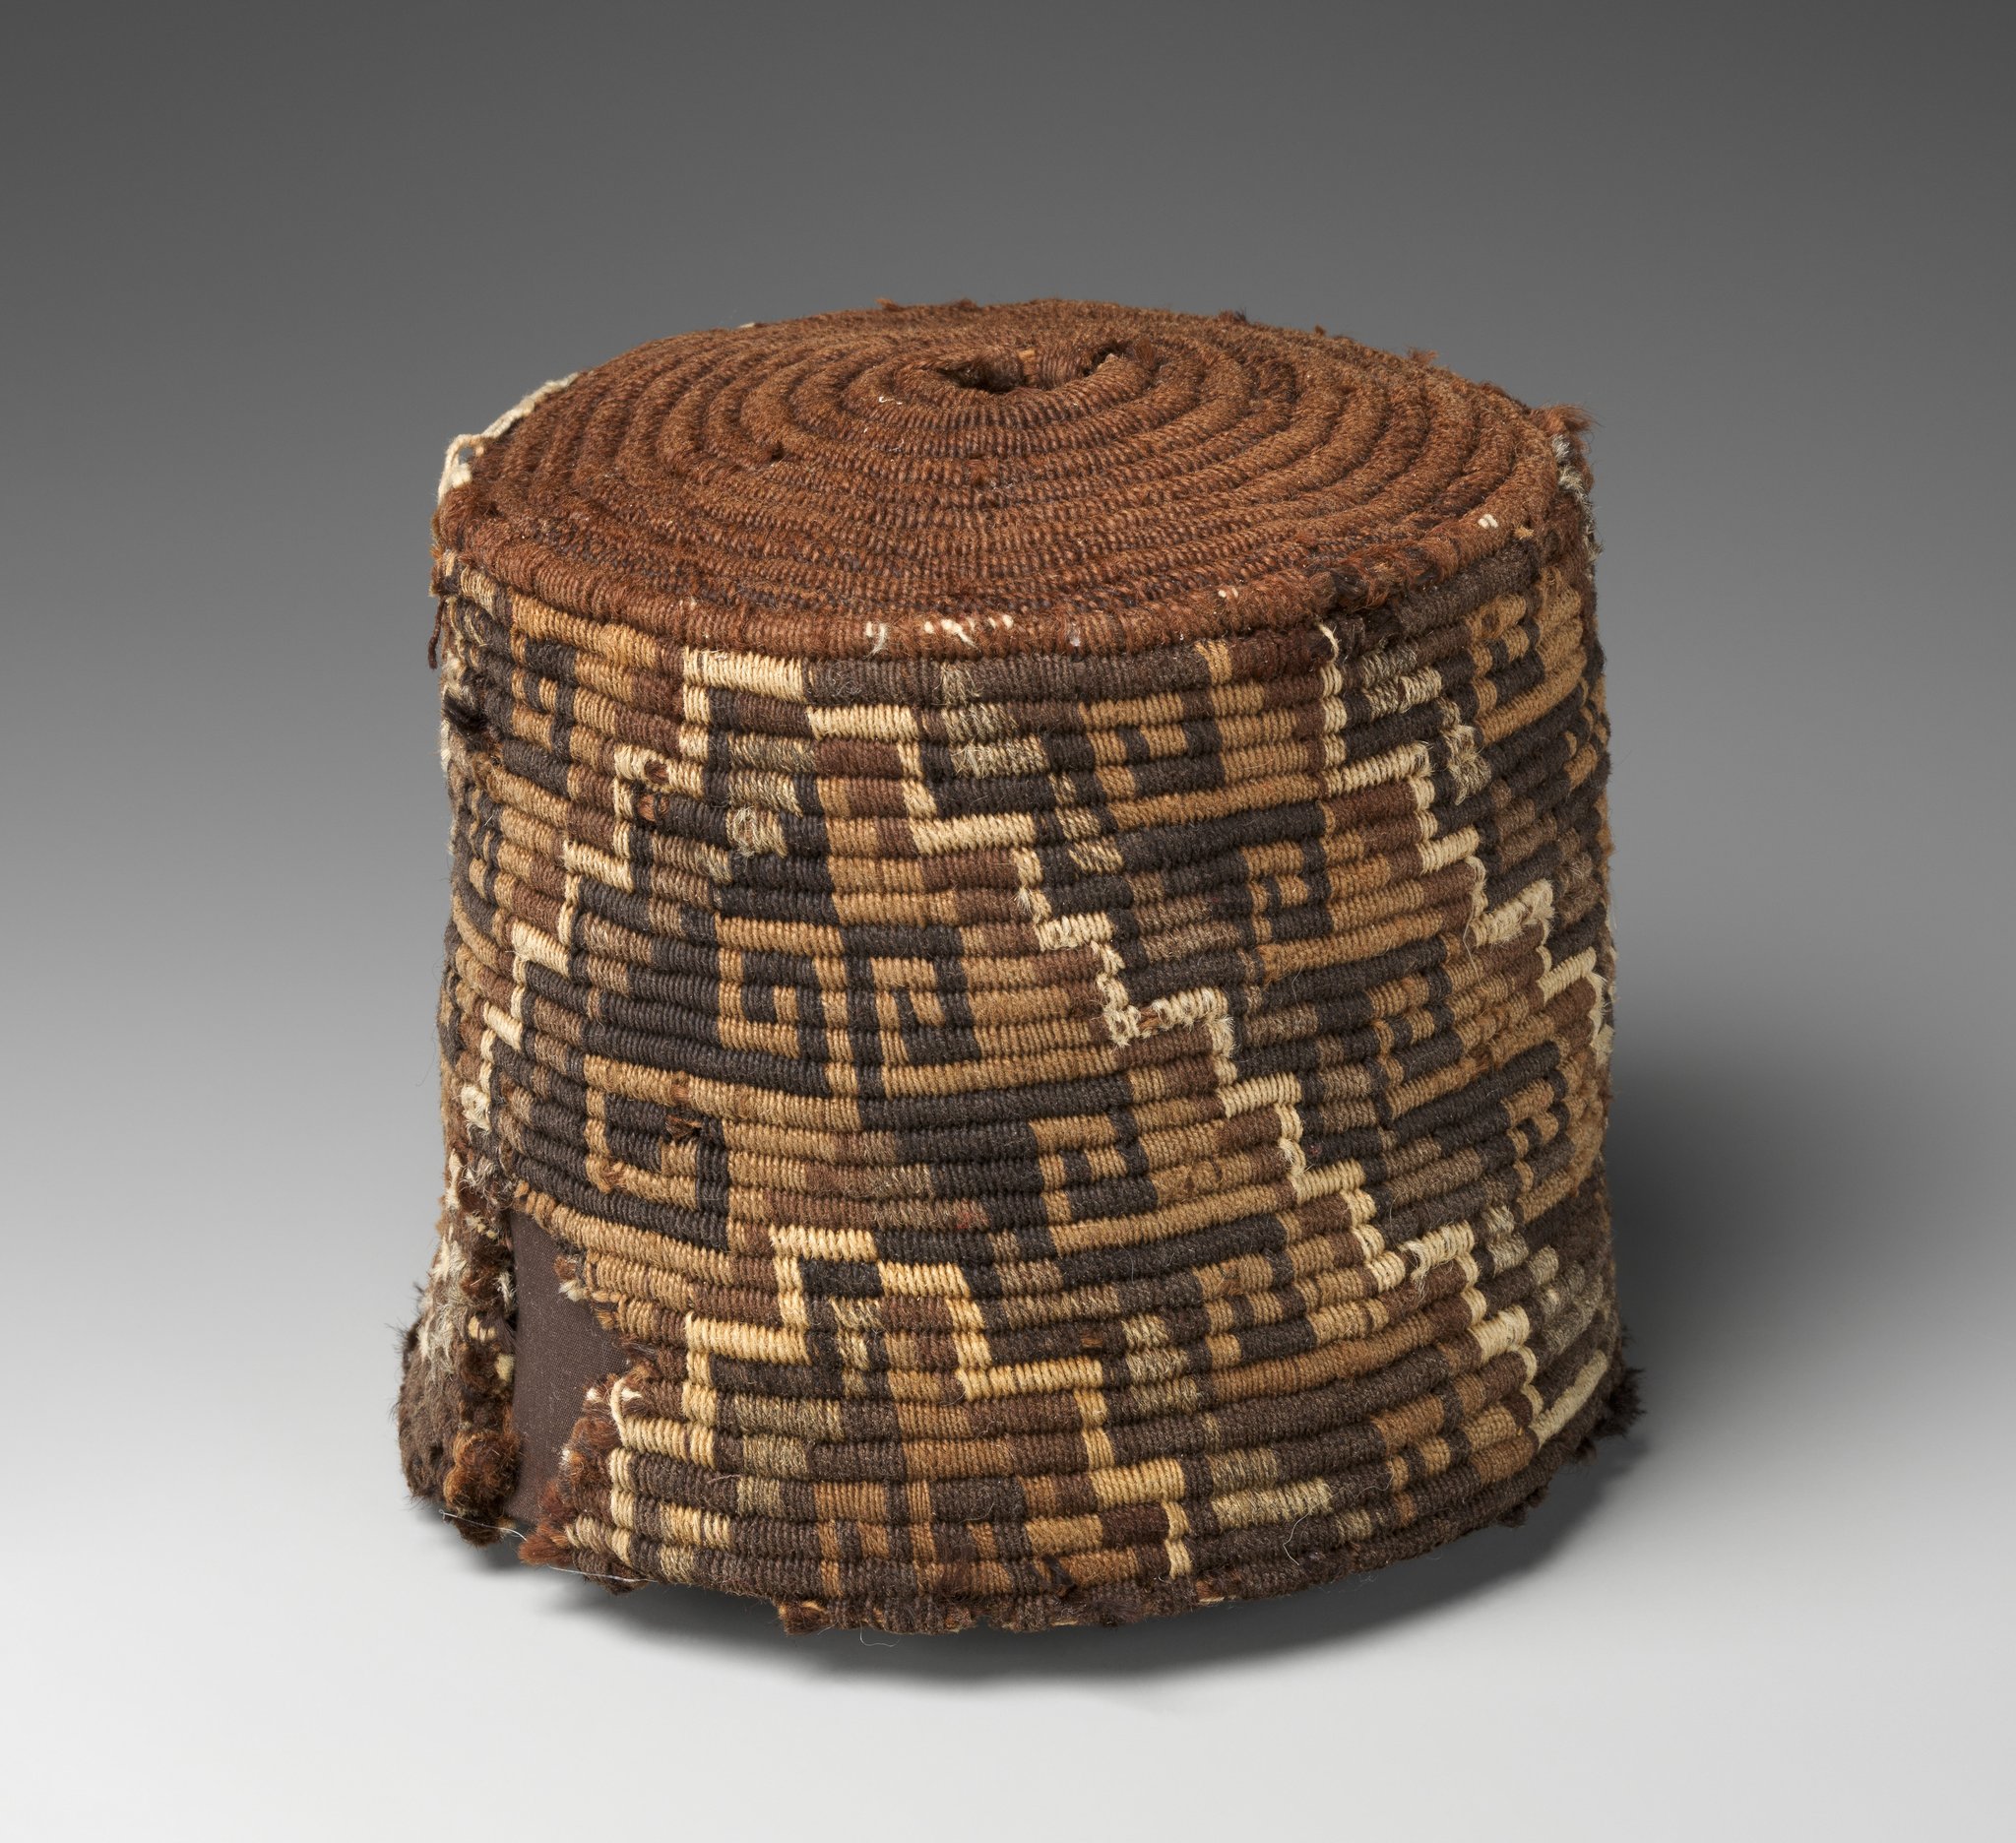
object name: hat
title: Cap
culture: arica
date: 901-1400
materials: animal fiber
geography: chile